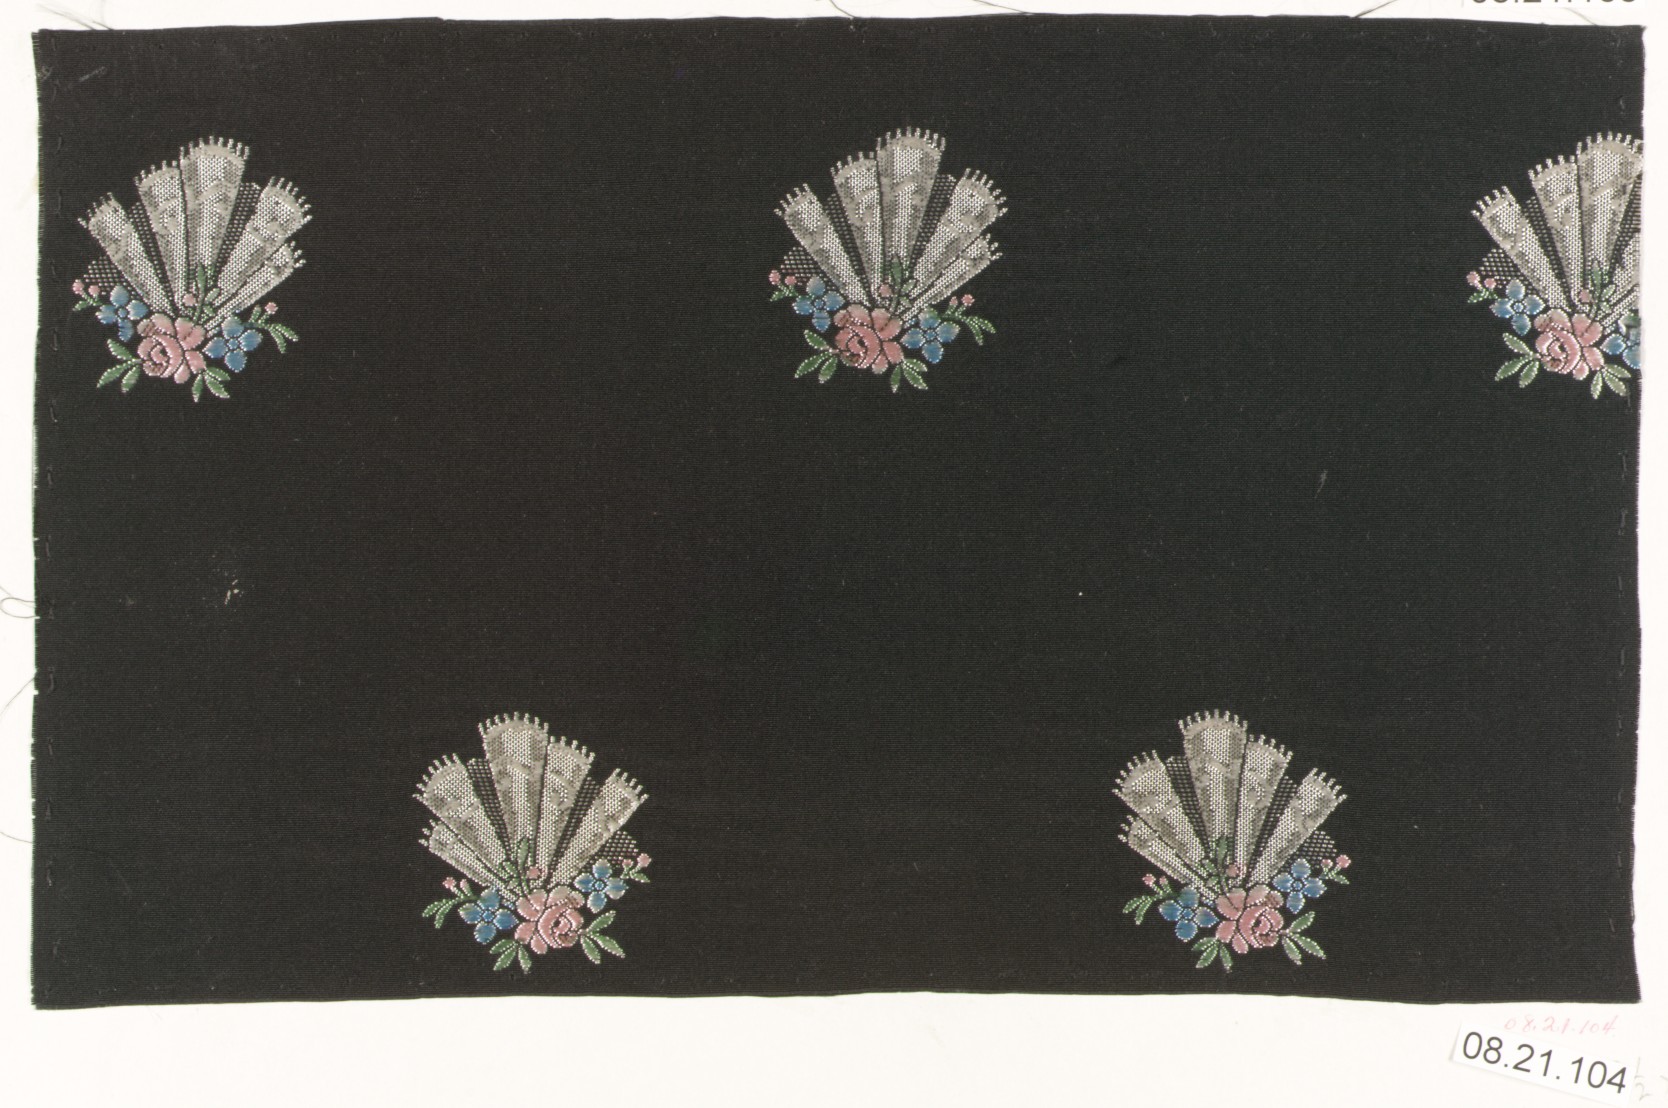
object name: textile sample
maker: Anonymous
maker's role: designer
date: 1900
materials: silk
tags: flowers